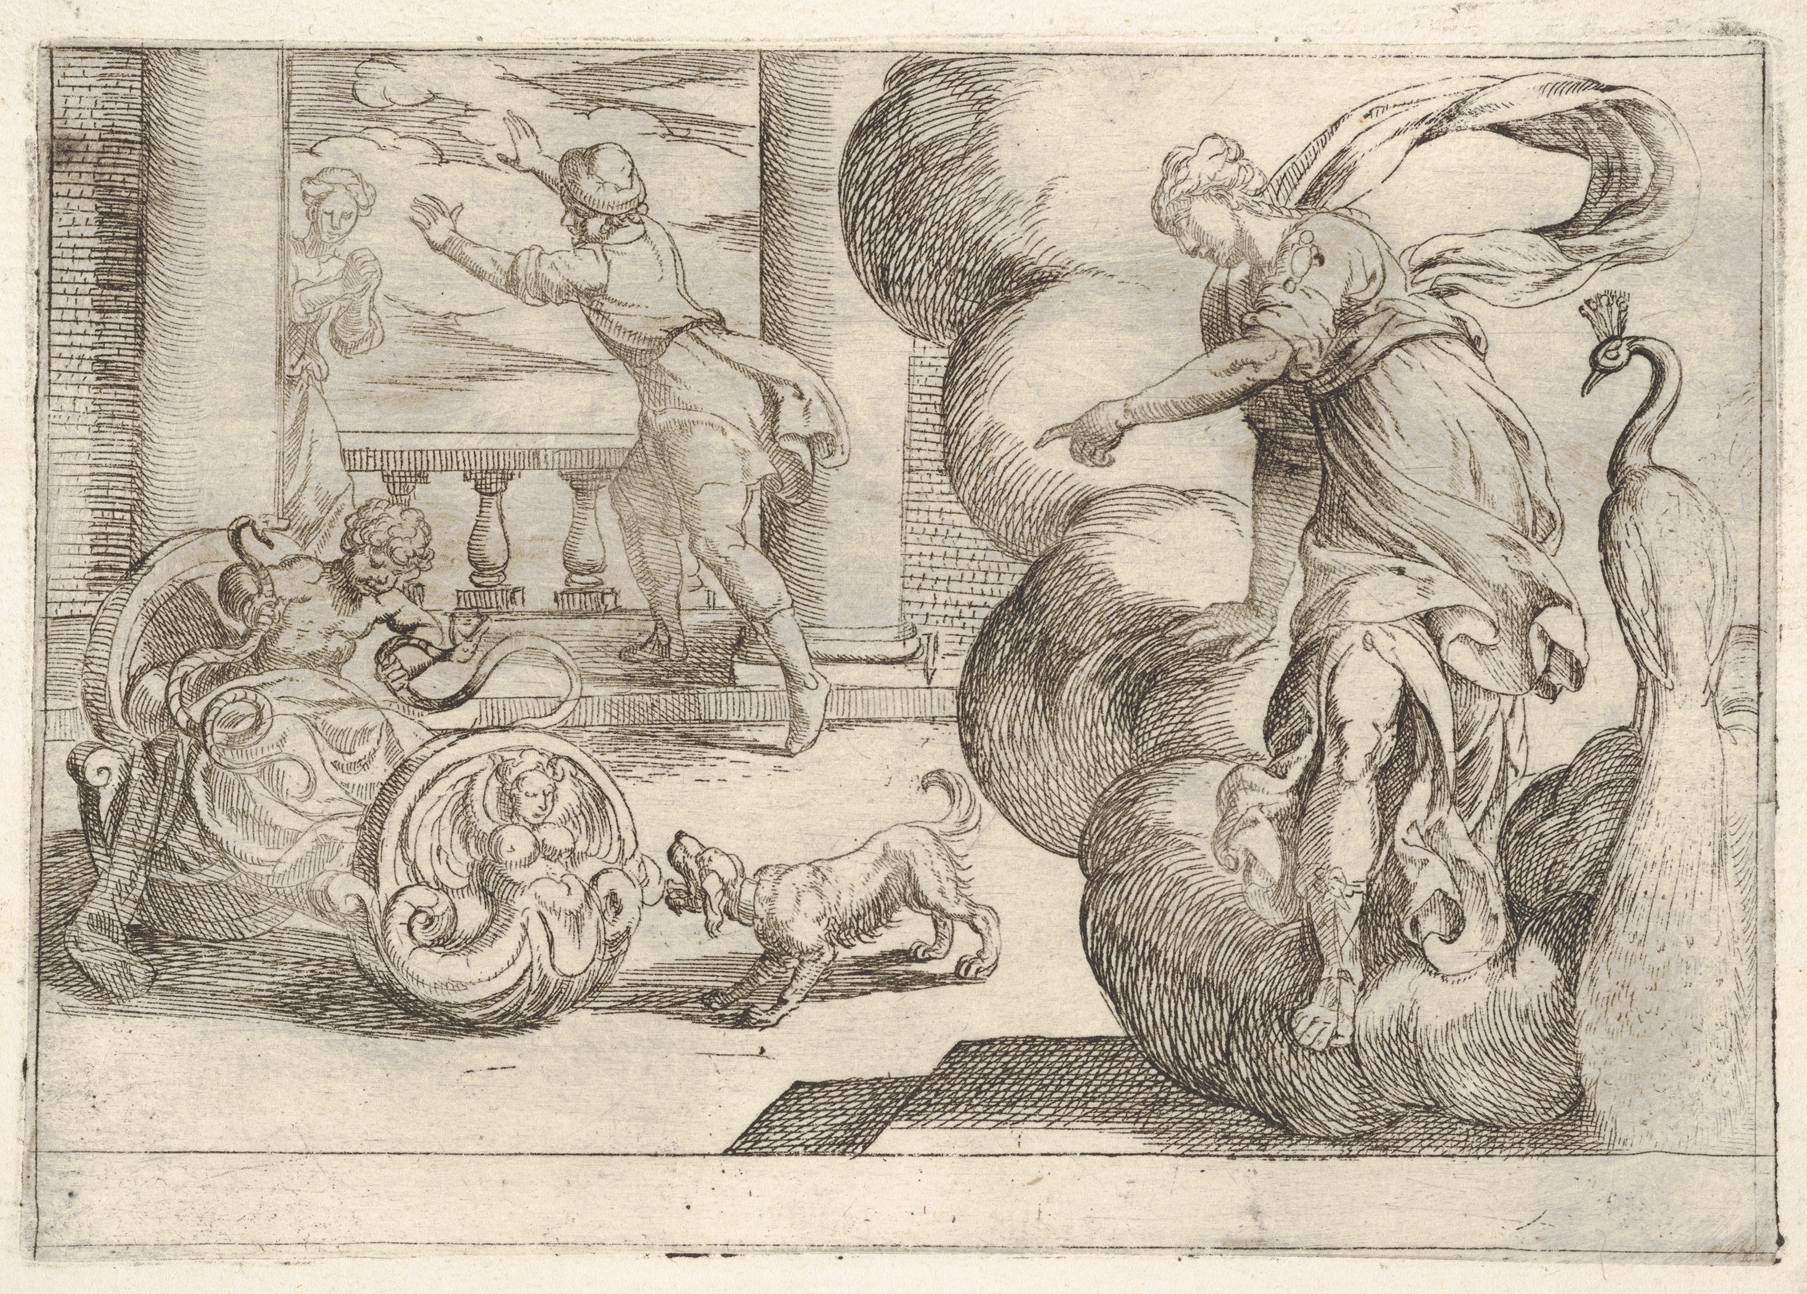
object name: print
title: Hercules strangling the serpents, from "The Labors of Hercules"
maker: antonio tempesta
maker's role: artist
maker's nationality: italian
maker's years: 1555-1630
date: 1608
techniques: etching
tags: men,women,hercules,juno,serpents